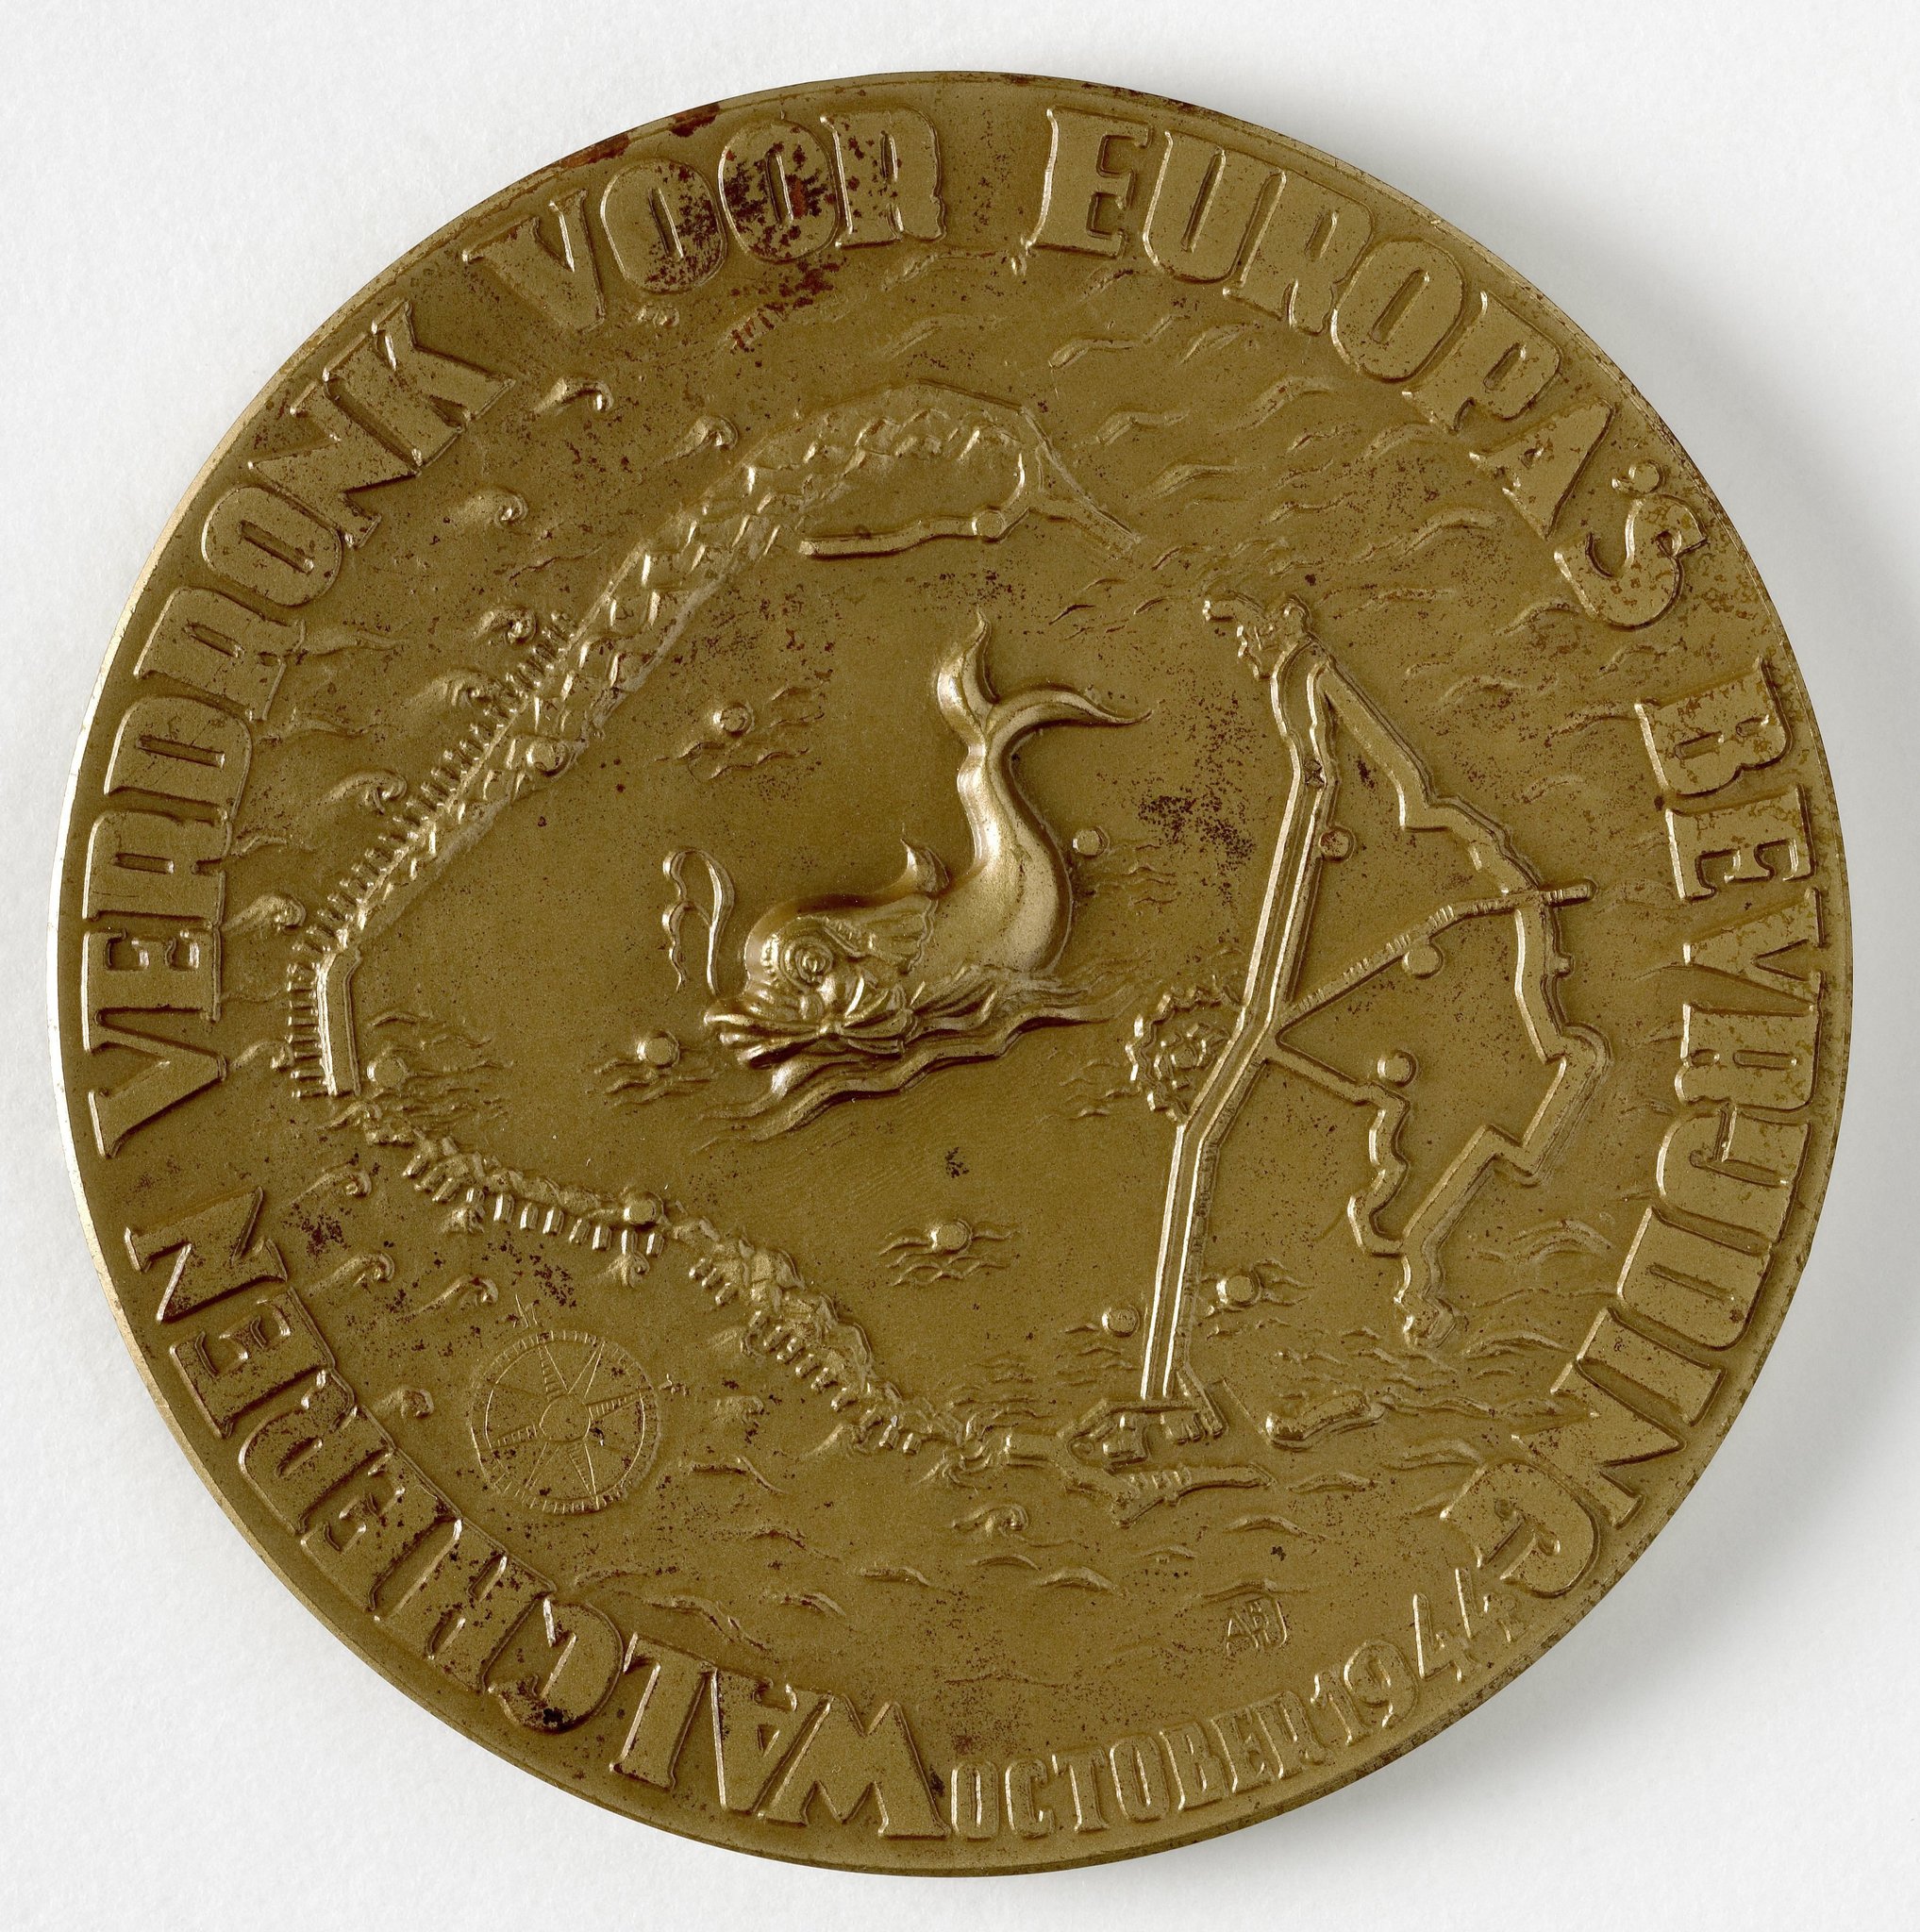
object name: medal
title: The Impoldering of Walcheren after the Second World War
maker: albert diekerhof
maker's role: sculptor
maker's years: 1917-1997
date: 1946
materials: bronze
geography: arnhem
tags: walcheren, bevrijding tweede wereldoorlog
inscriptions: circumscription: ‘Walcheren verdronk voor Europa's bevrijding October 1944’, signature: ‘AD’, inscription: ‘Door / kunde, maar door / wilskracht allermeest, / werd 't eiland Walcheren / uit den vloed geborgen, / een schip geteisterd door / een wild tempeest, maar / zeilree toch naar / 't / vredig licht van / morgen. / Februari / 1946’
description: Flood Disaster Medals. Much of the Netherlands lies below sea level. The threat of flooding is thus ever-present. Dikes, dams and polders were created to control the water. Still, these safety measures sometimes failed. Each century witnessed disastrous floods, with levees breaching and the countryside being inundated. The North Sea Flood of 1953 led to the construction of the Delta Works. Thanks to this major intervention the country has since remained dry.